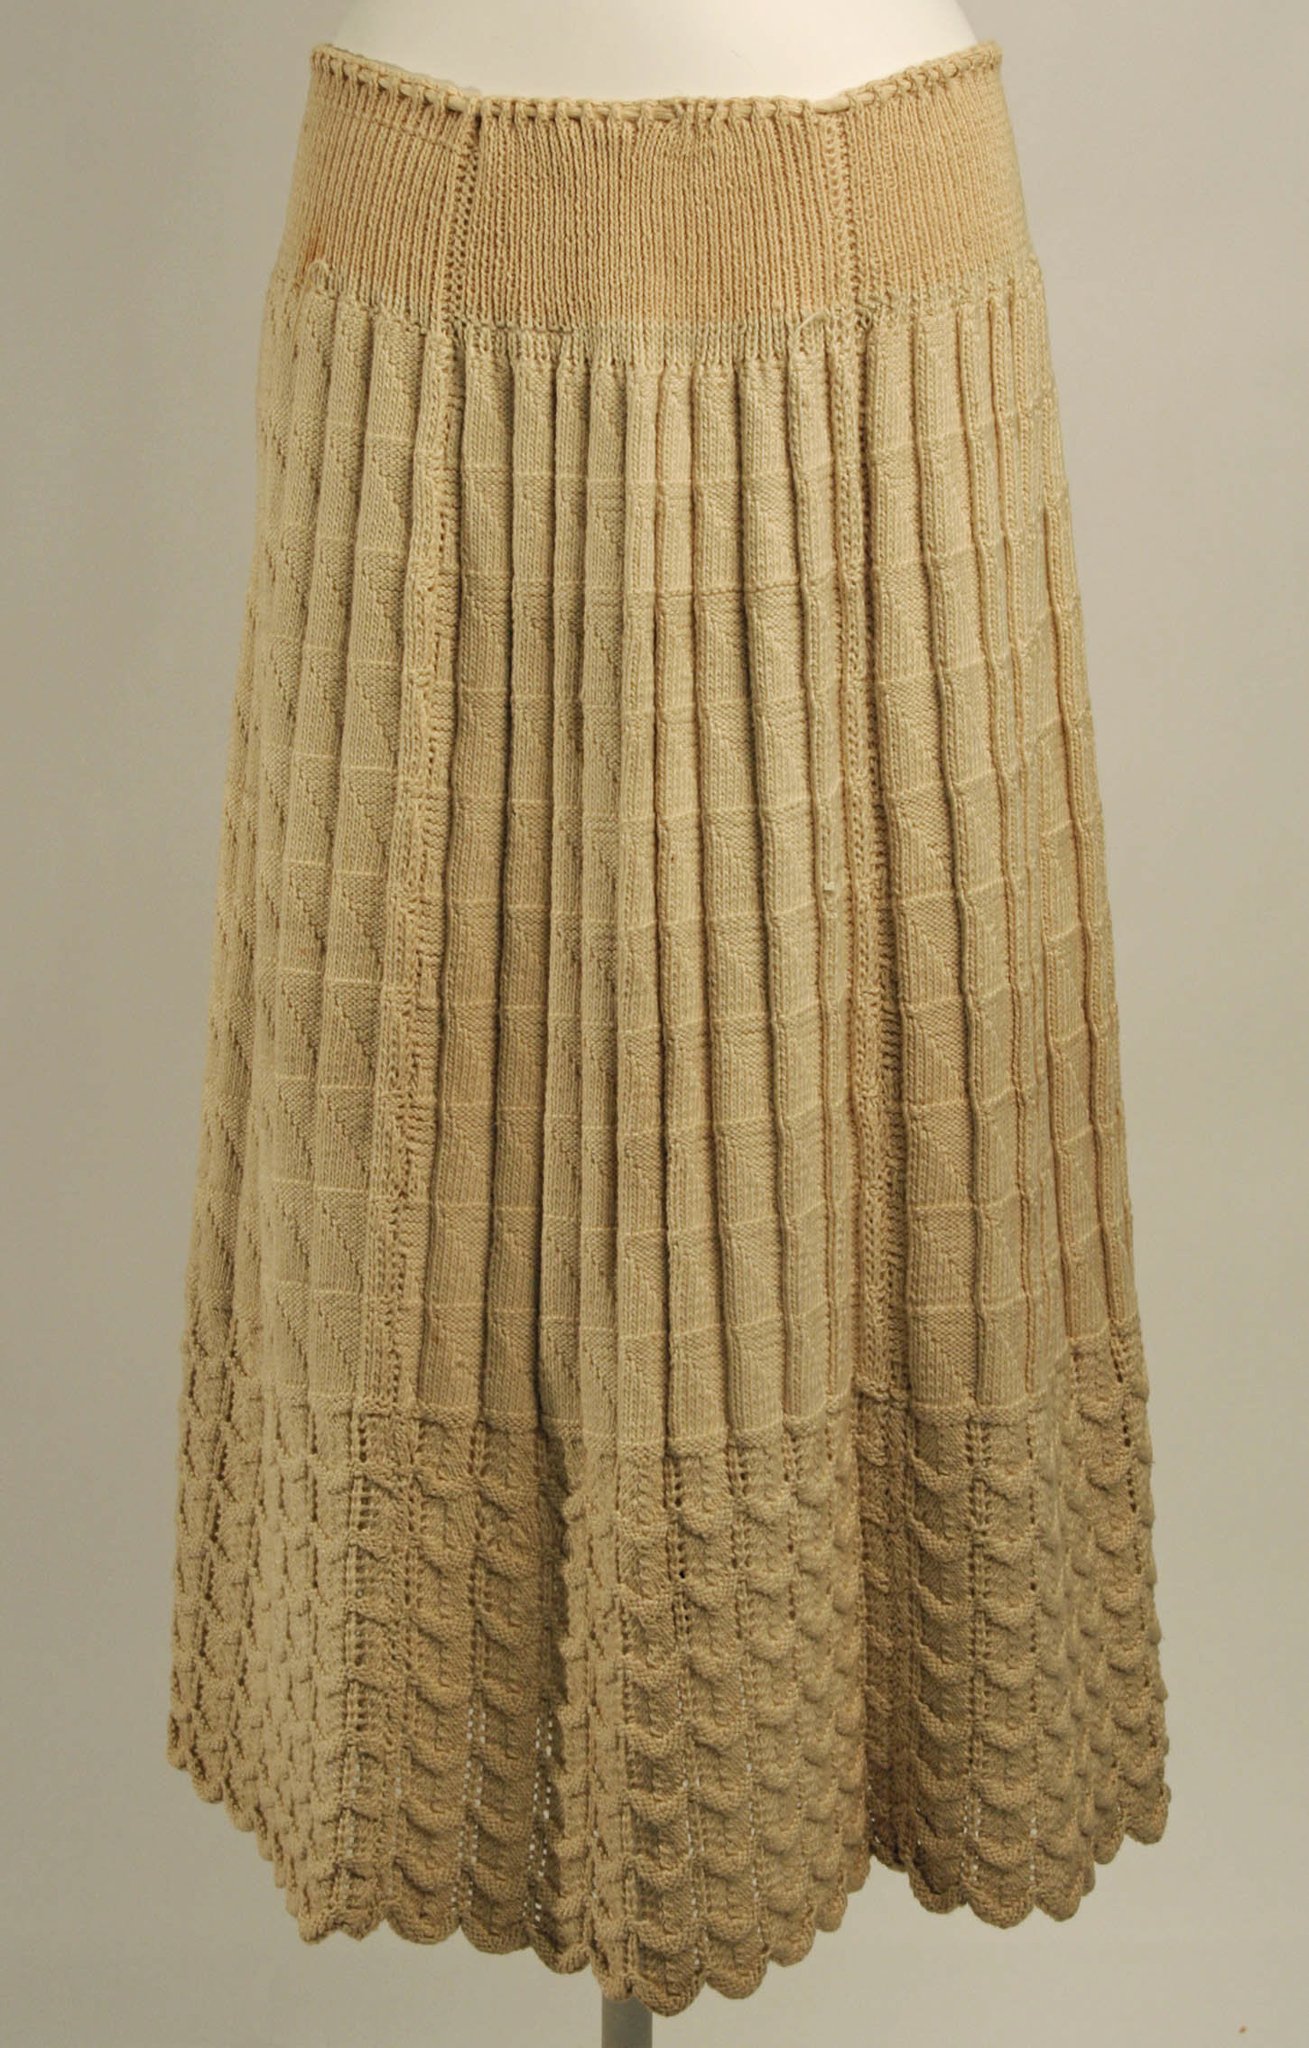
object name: petticoat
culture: american or european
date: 1867-1933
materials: wool